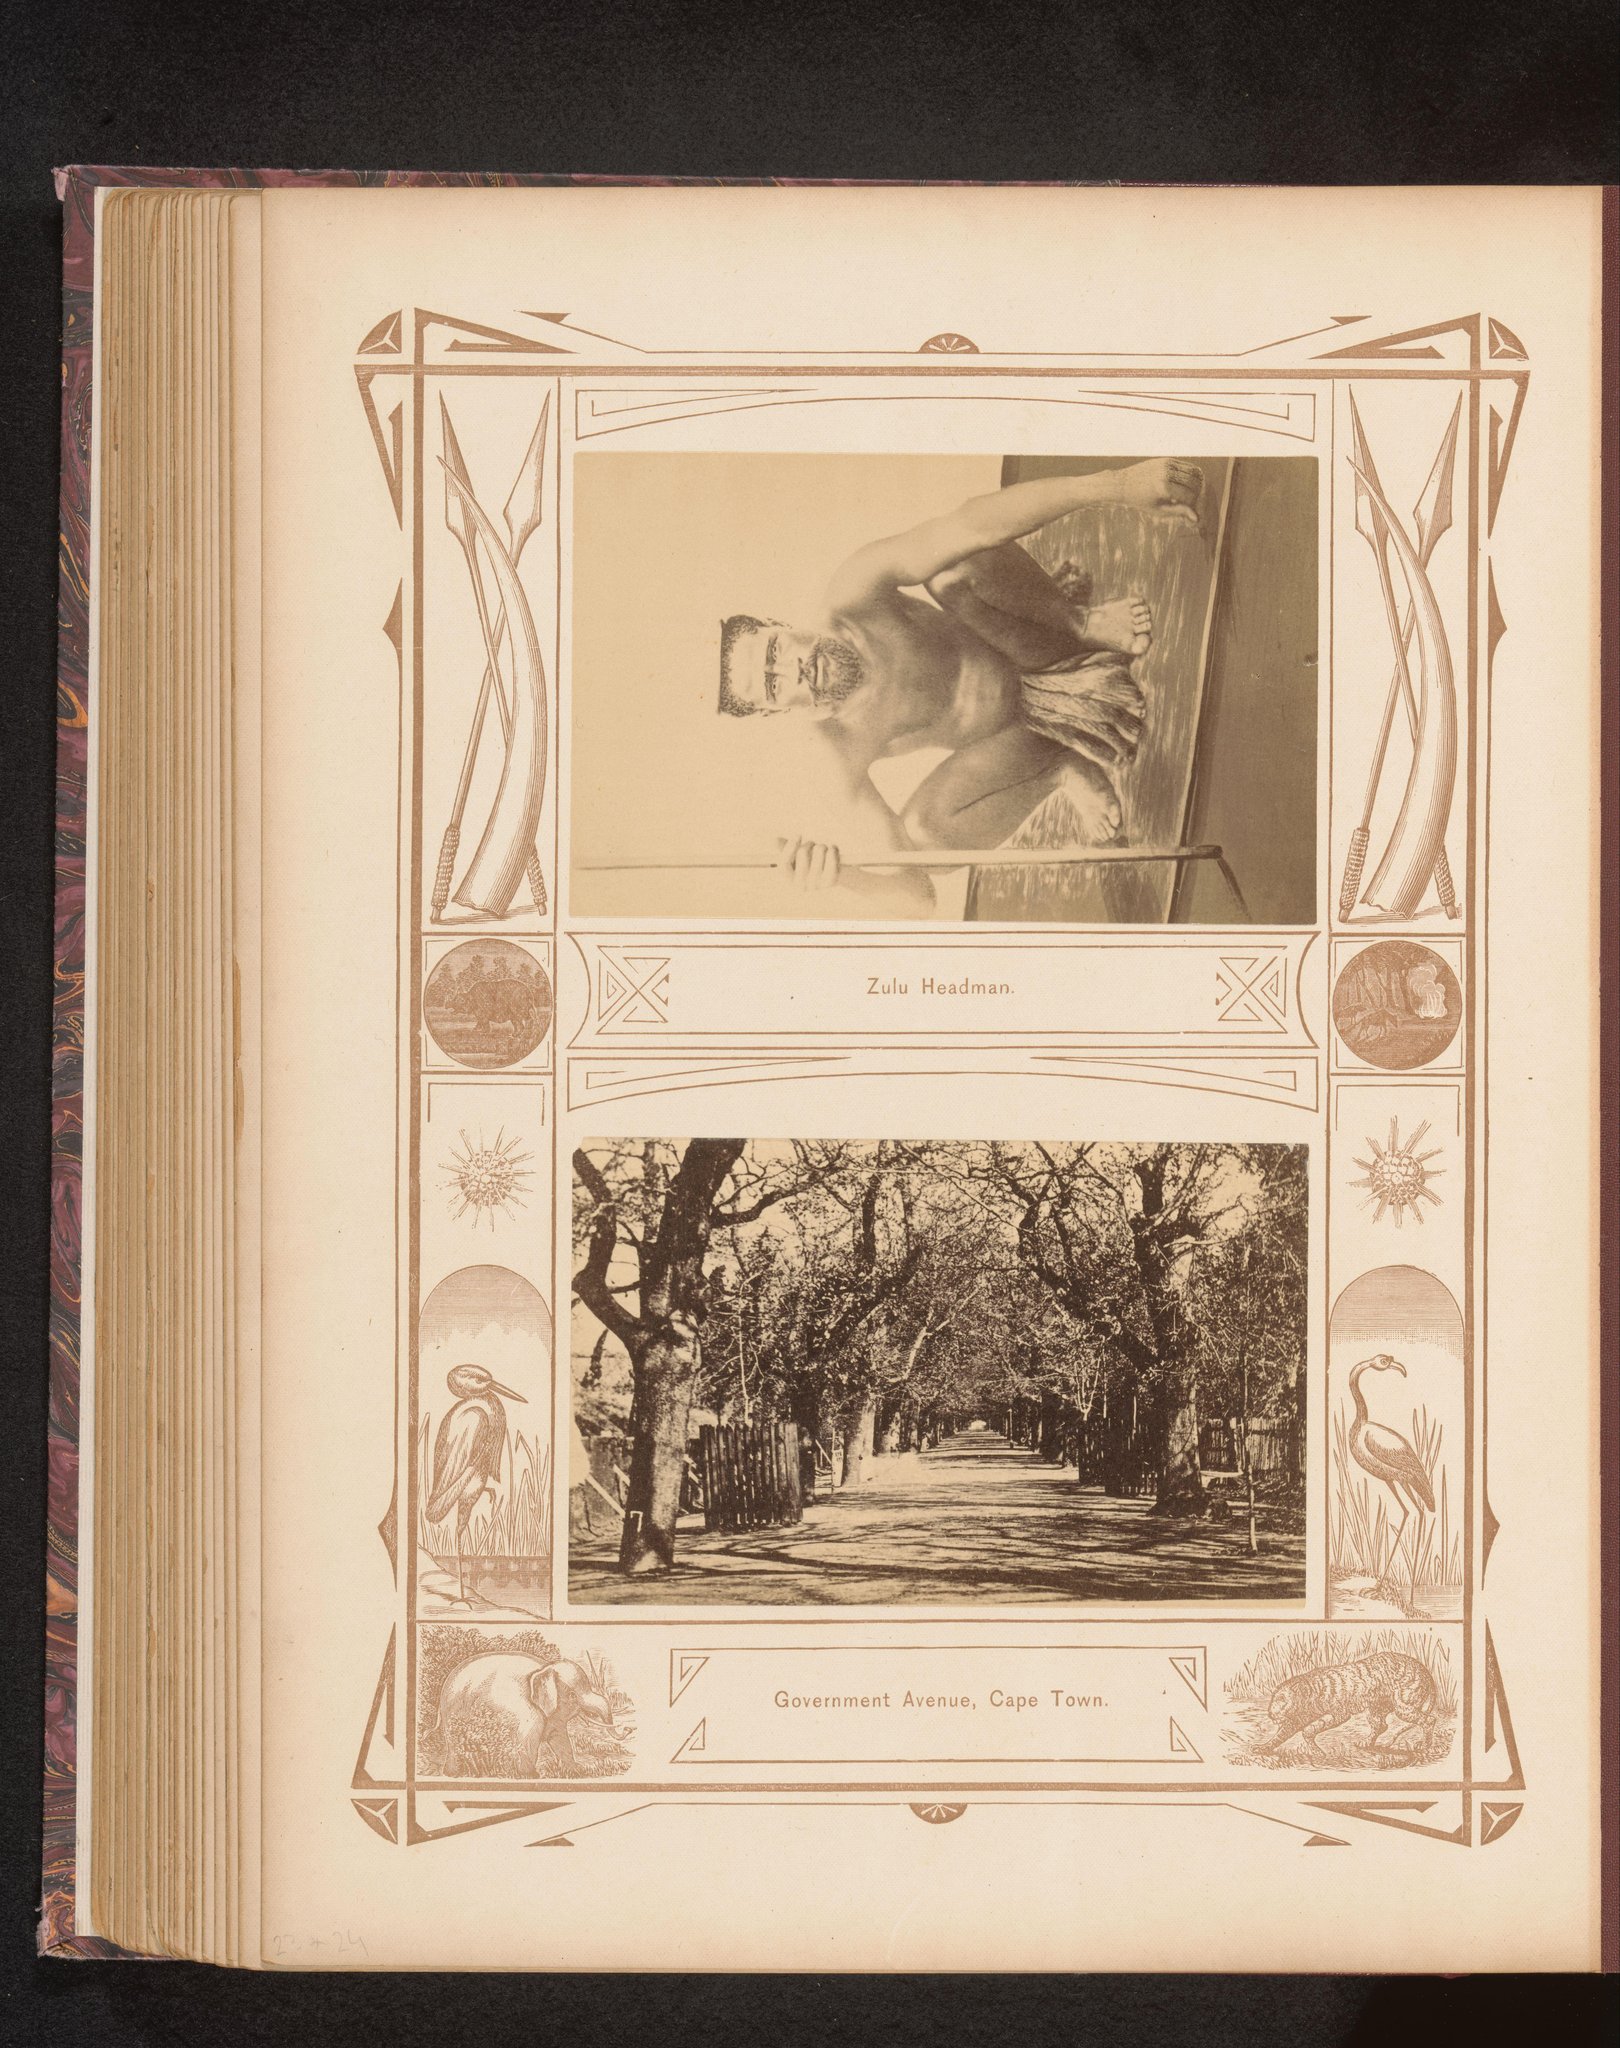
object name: page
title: Portret van een Zoeloe leider in klederdracht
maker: Anonymous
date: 1877-1882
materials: photographic support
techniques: albumen print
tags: africans, adult man, historical persons